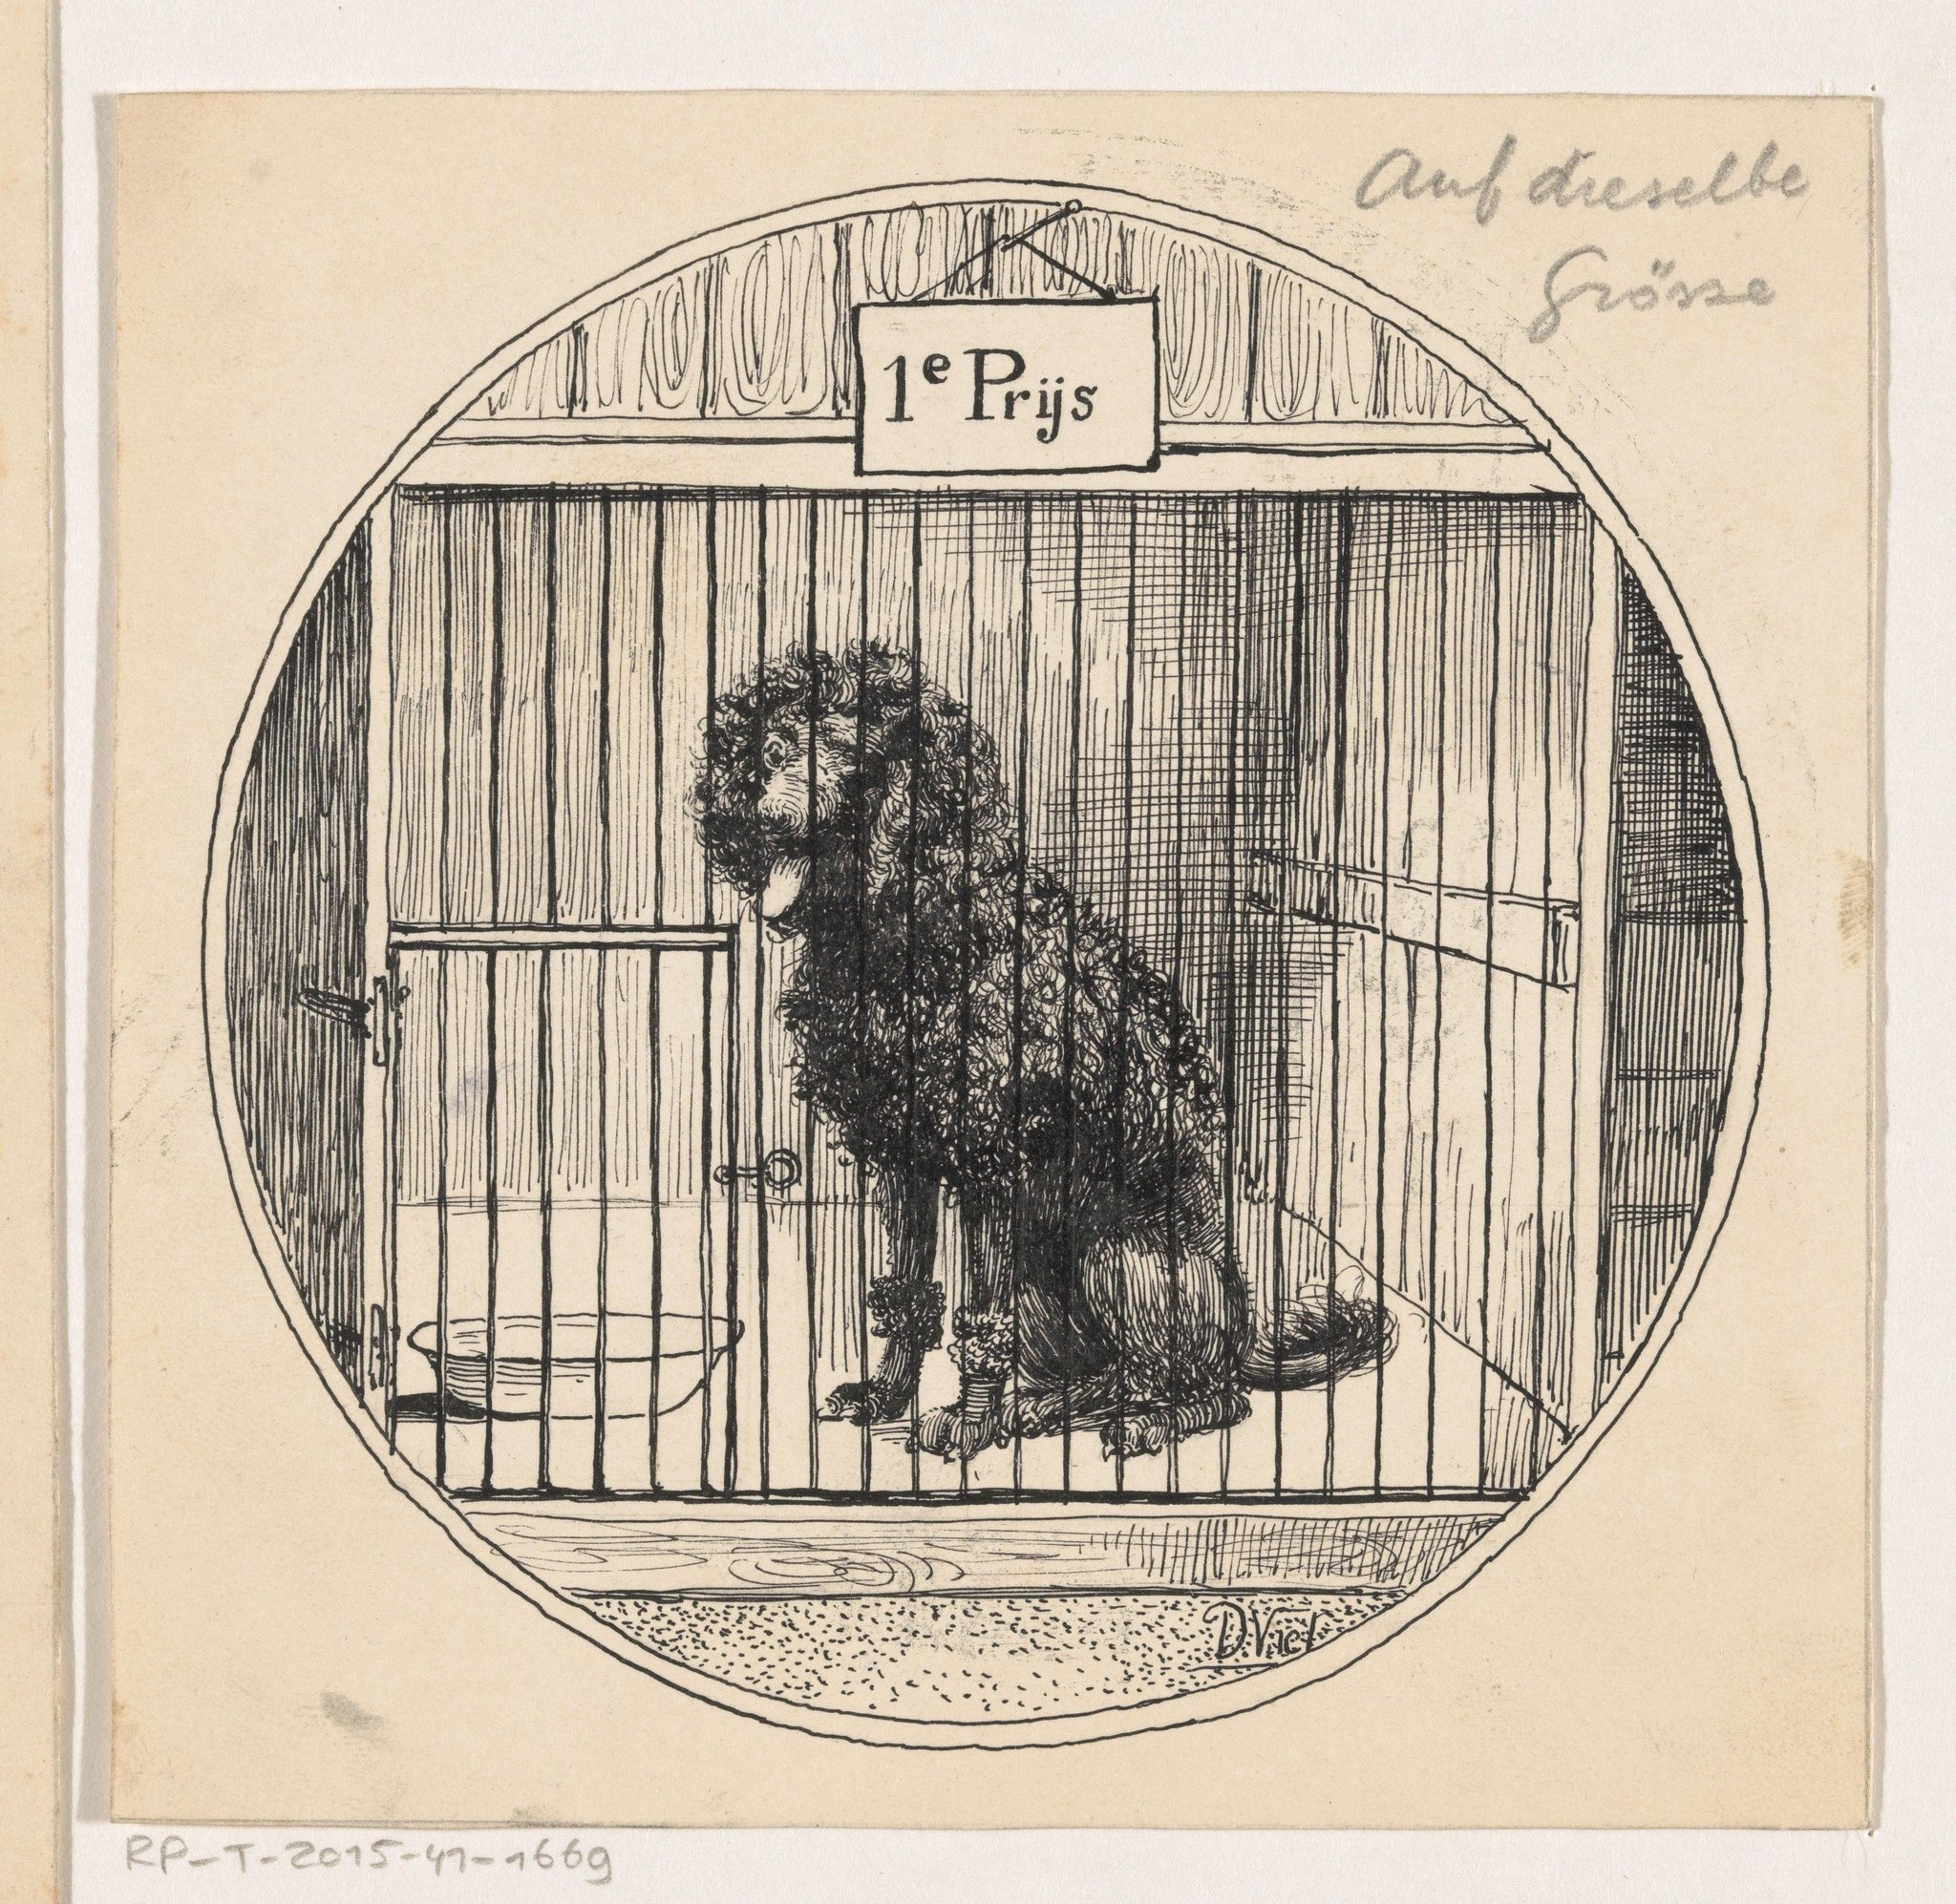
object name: drawing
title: Hond in kooi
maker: d. viel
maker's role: draughtsman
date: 1915-1935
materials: ink, paper, pencil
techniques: pen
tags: dog (+ animal cage), dog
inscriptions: collector's mark: Lugt 2228, signature: ‘D Viel’, :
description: Een hond zit met de tong uit de bek in een kooi. Op de vloer van de kooi staat een kom. Aan de buitenkant van de kooi hangt een bord met daarop de tekst: '1e Prijs'.